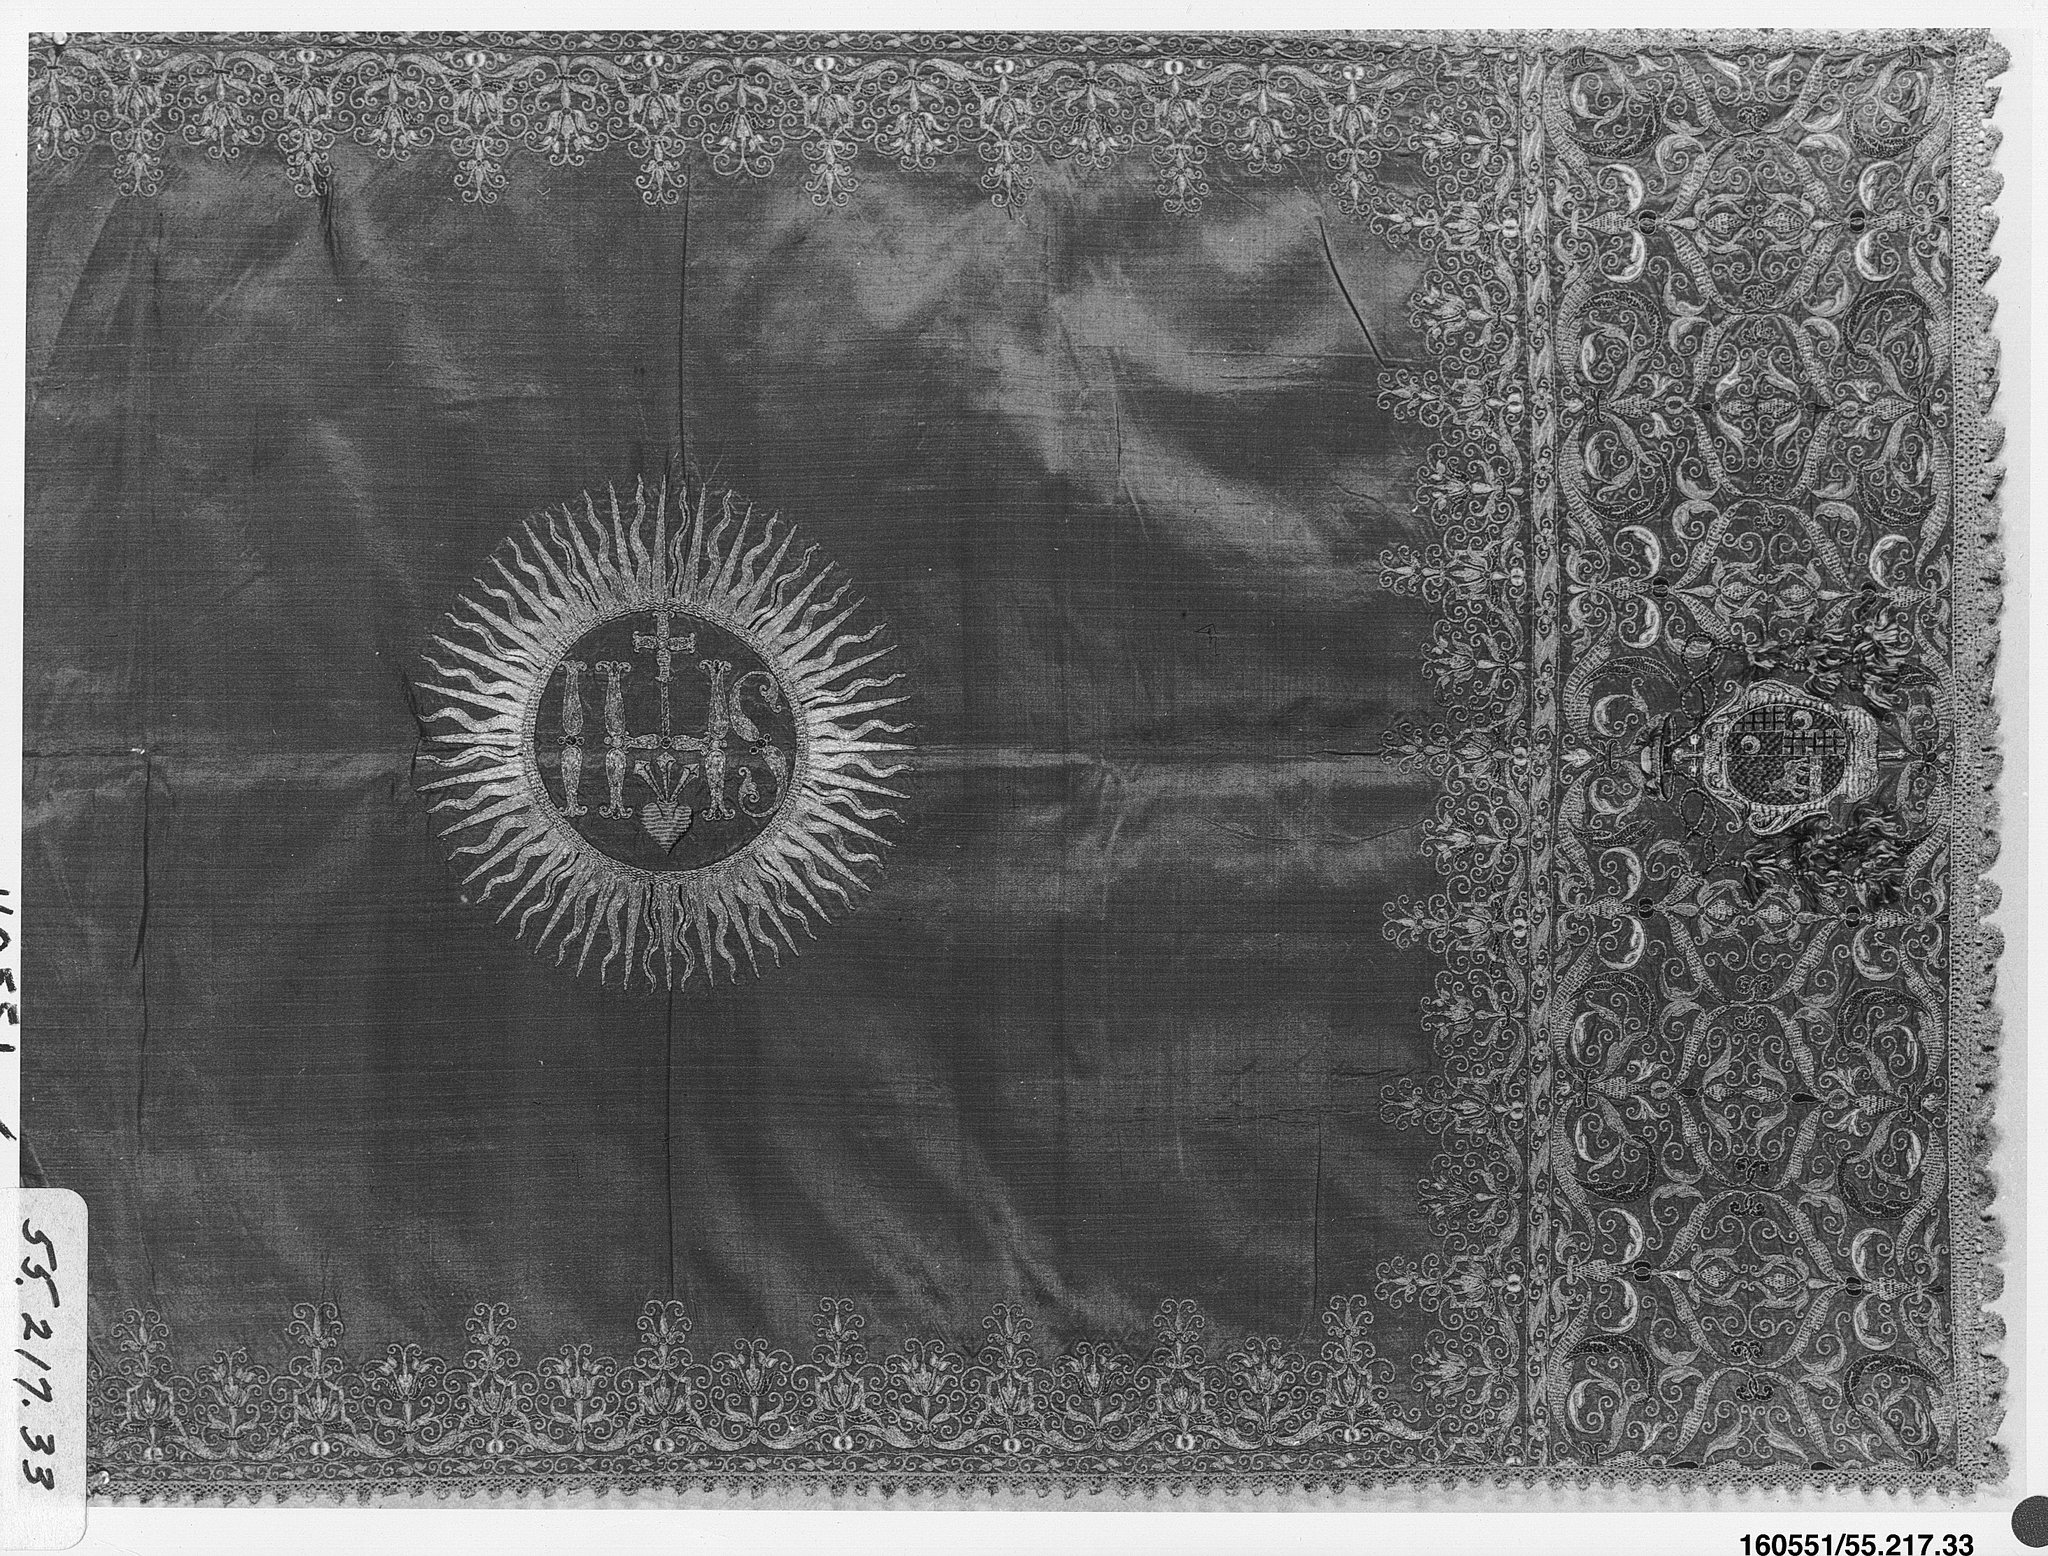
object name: altar frontal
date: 1600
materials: metal thread, silk